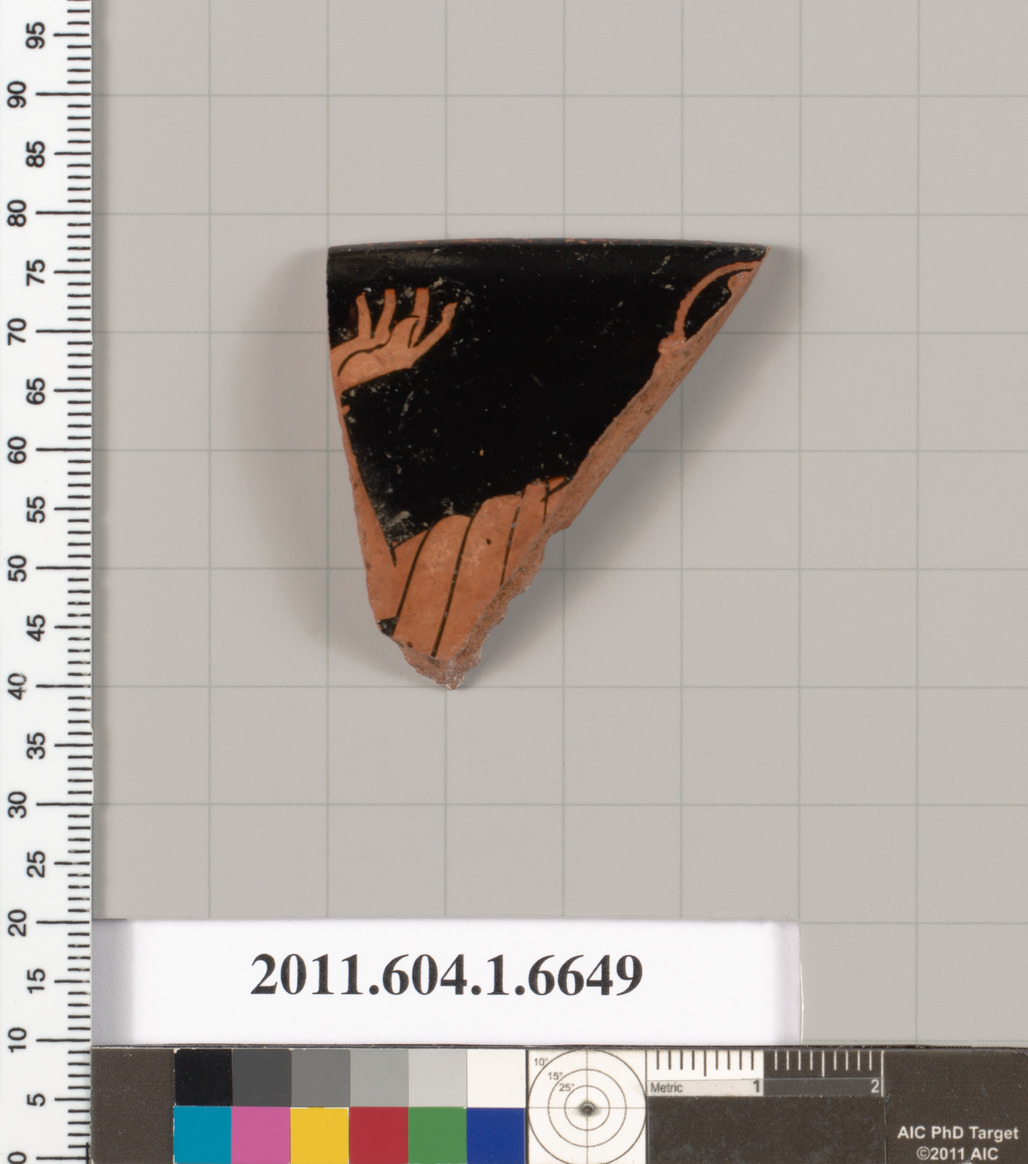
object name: kylix fragment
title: Terracotta rim fragment of a kylix (drinking cup)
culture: greek, attic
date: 490-470 BCE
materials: terracotta